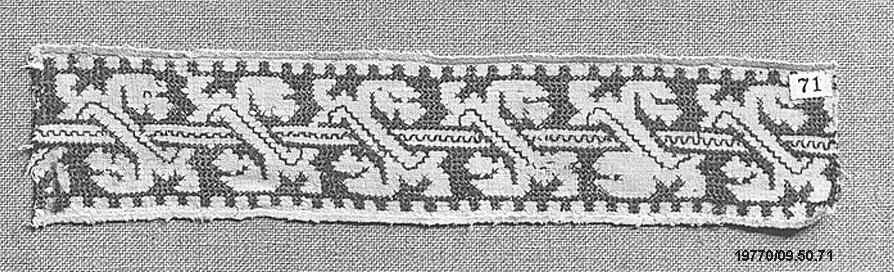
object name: border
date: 1501-1700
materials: linen, silk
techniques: embroidery